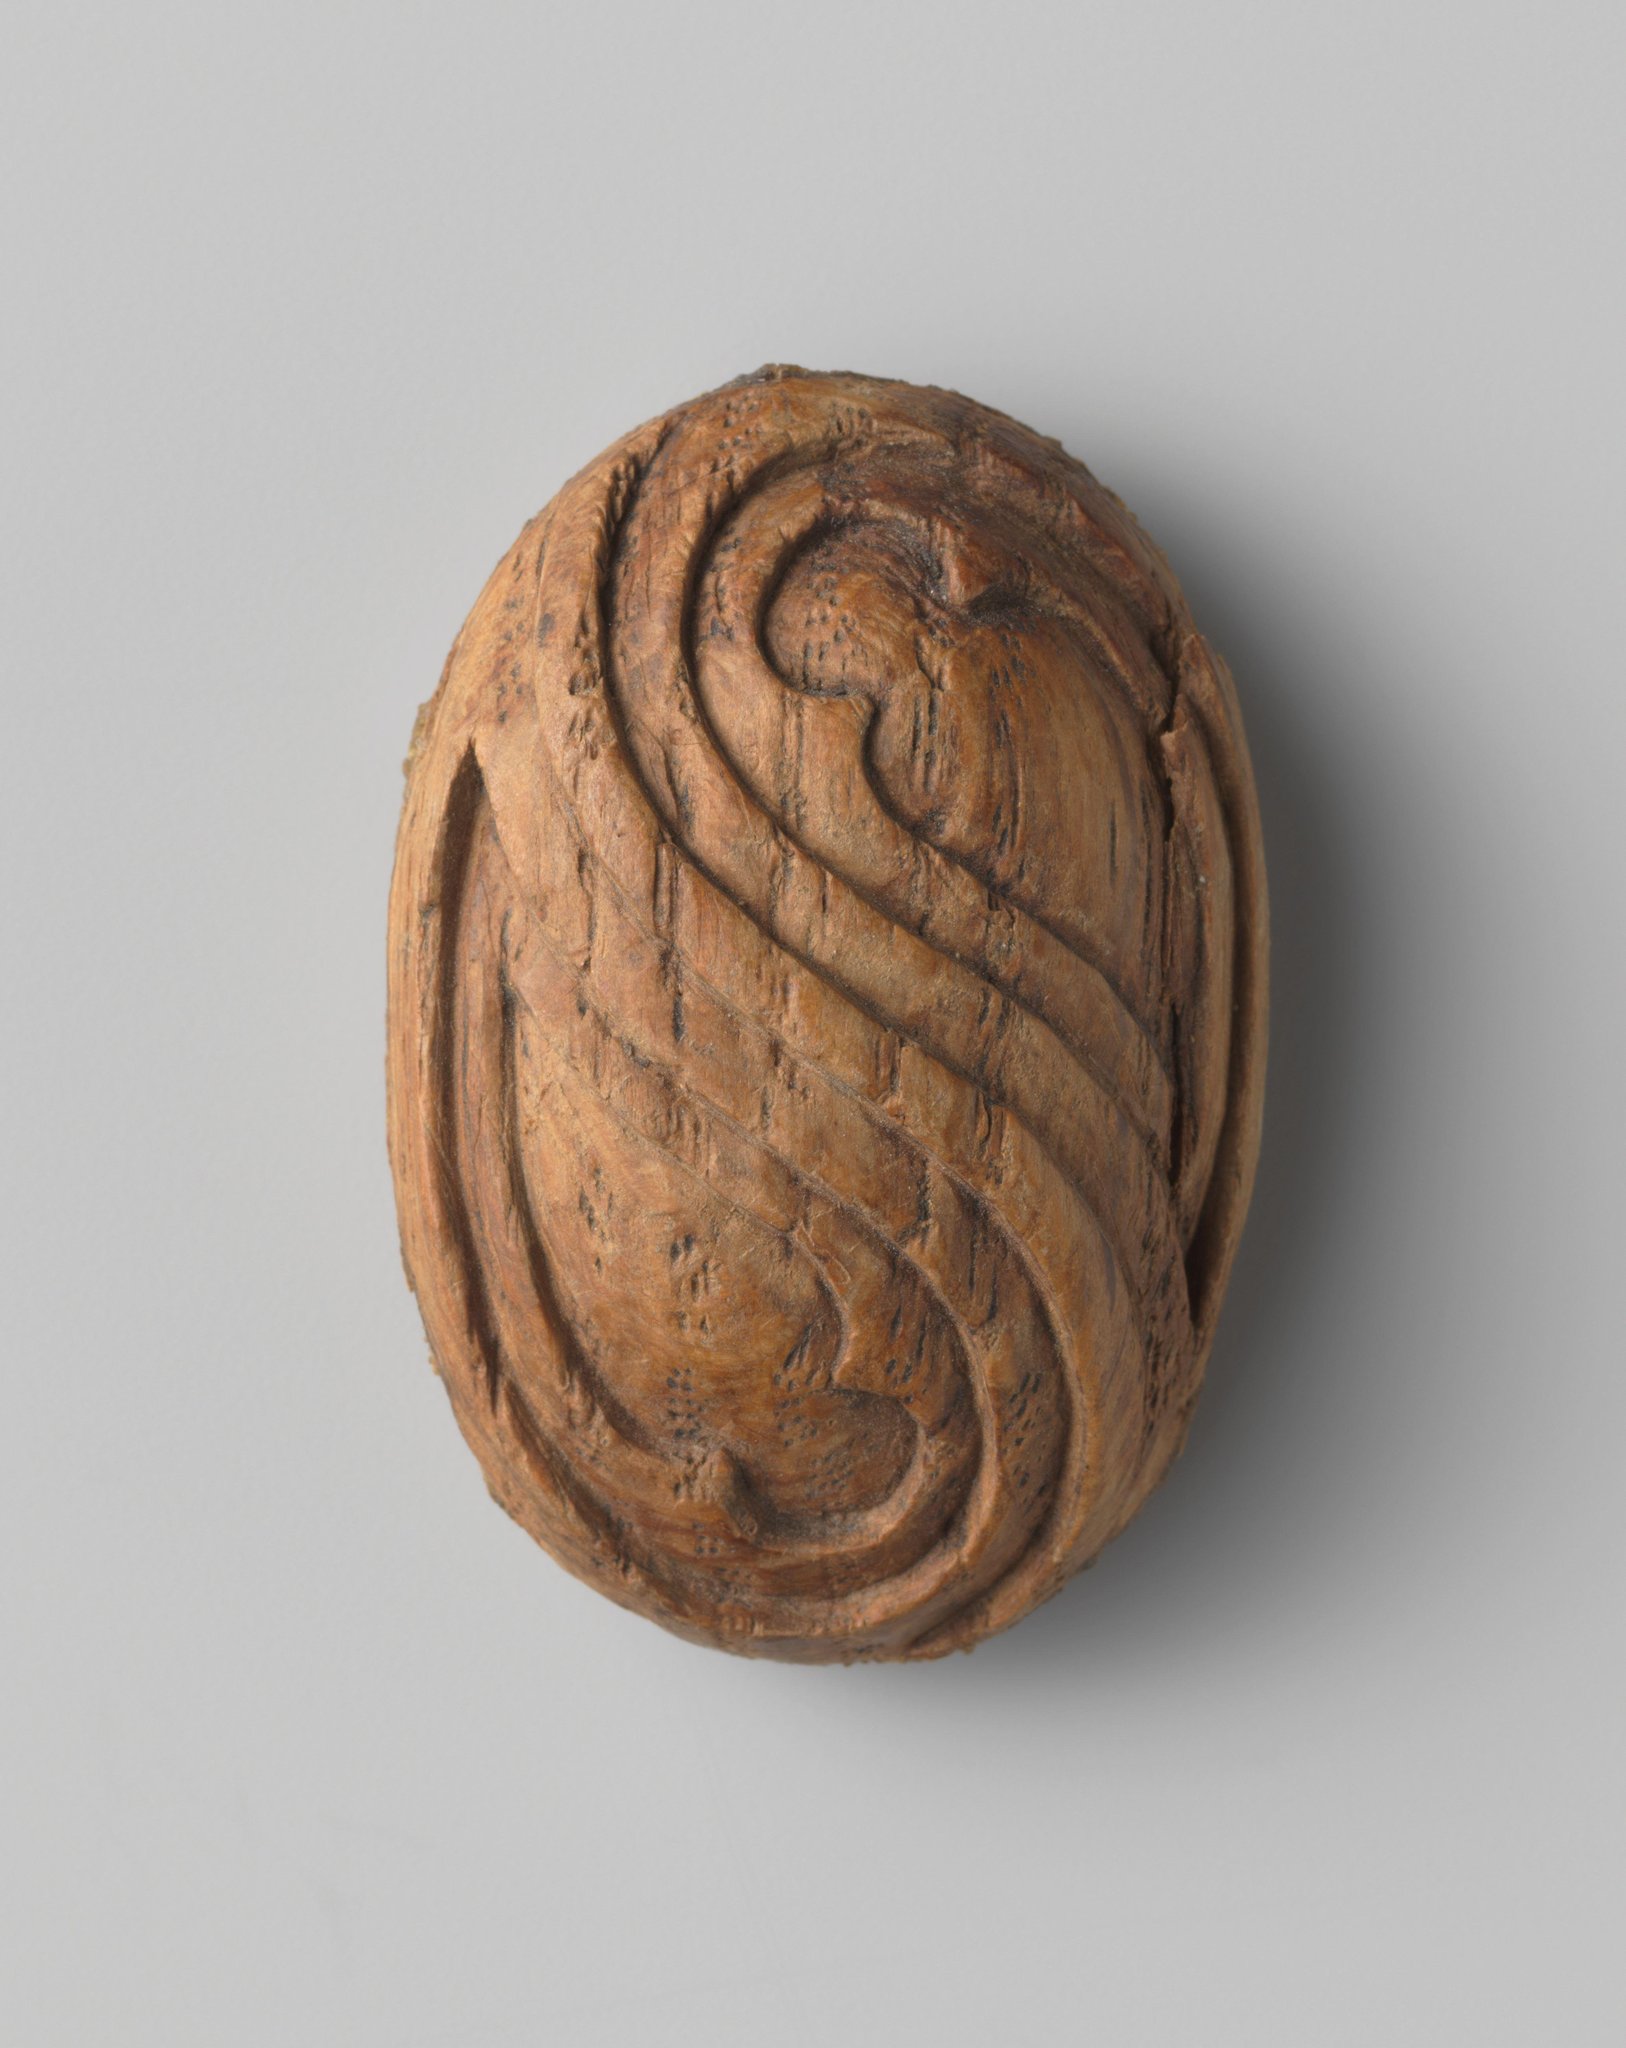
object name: sculpture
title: God the Father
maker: master of the madonna of la gleize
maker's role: sculptor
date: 1330-1360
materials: wood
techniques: carved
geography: liège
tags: coronation of mary by christ (+ variant)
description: Ovale bedekking van de reliekruimte op de borst. Later toegevoegd en bij restauratie verwijderd.